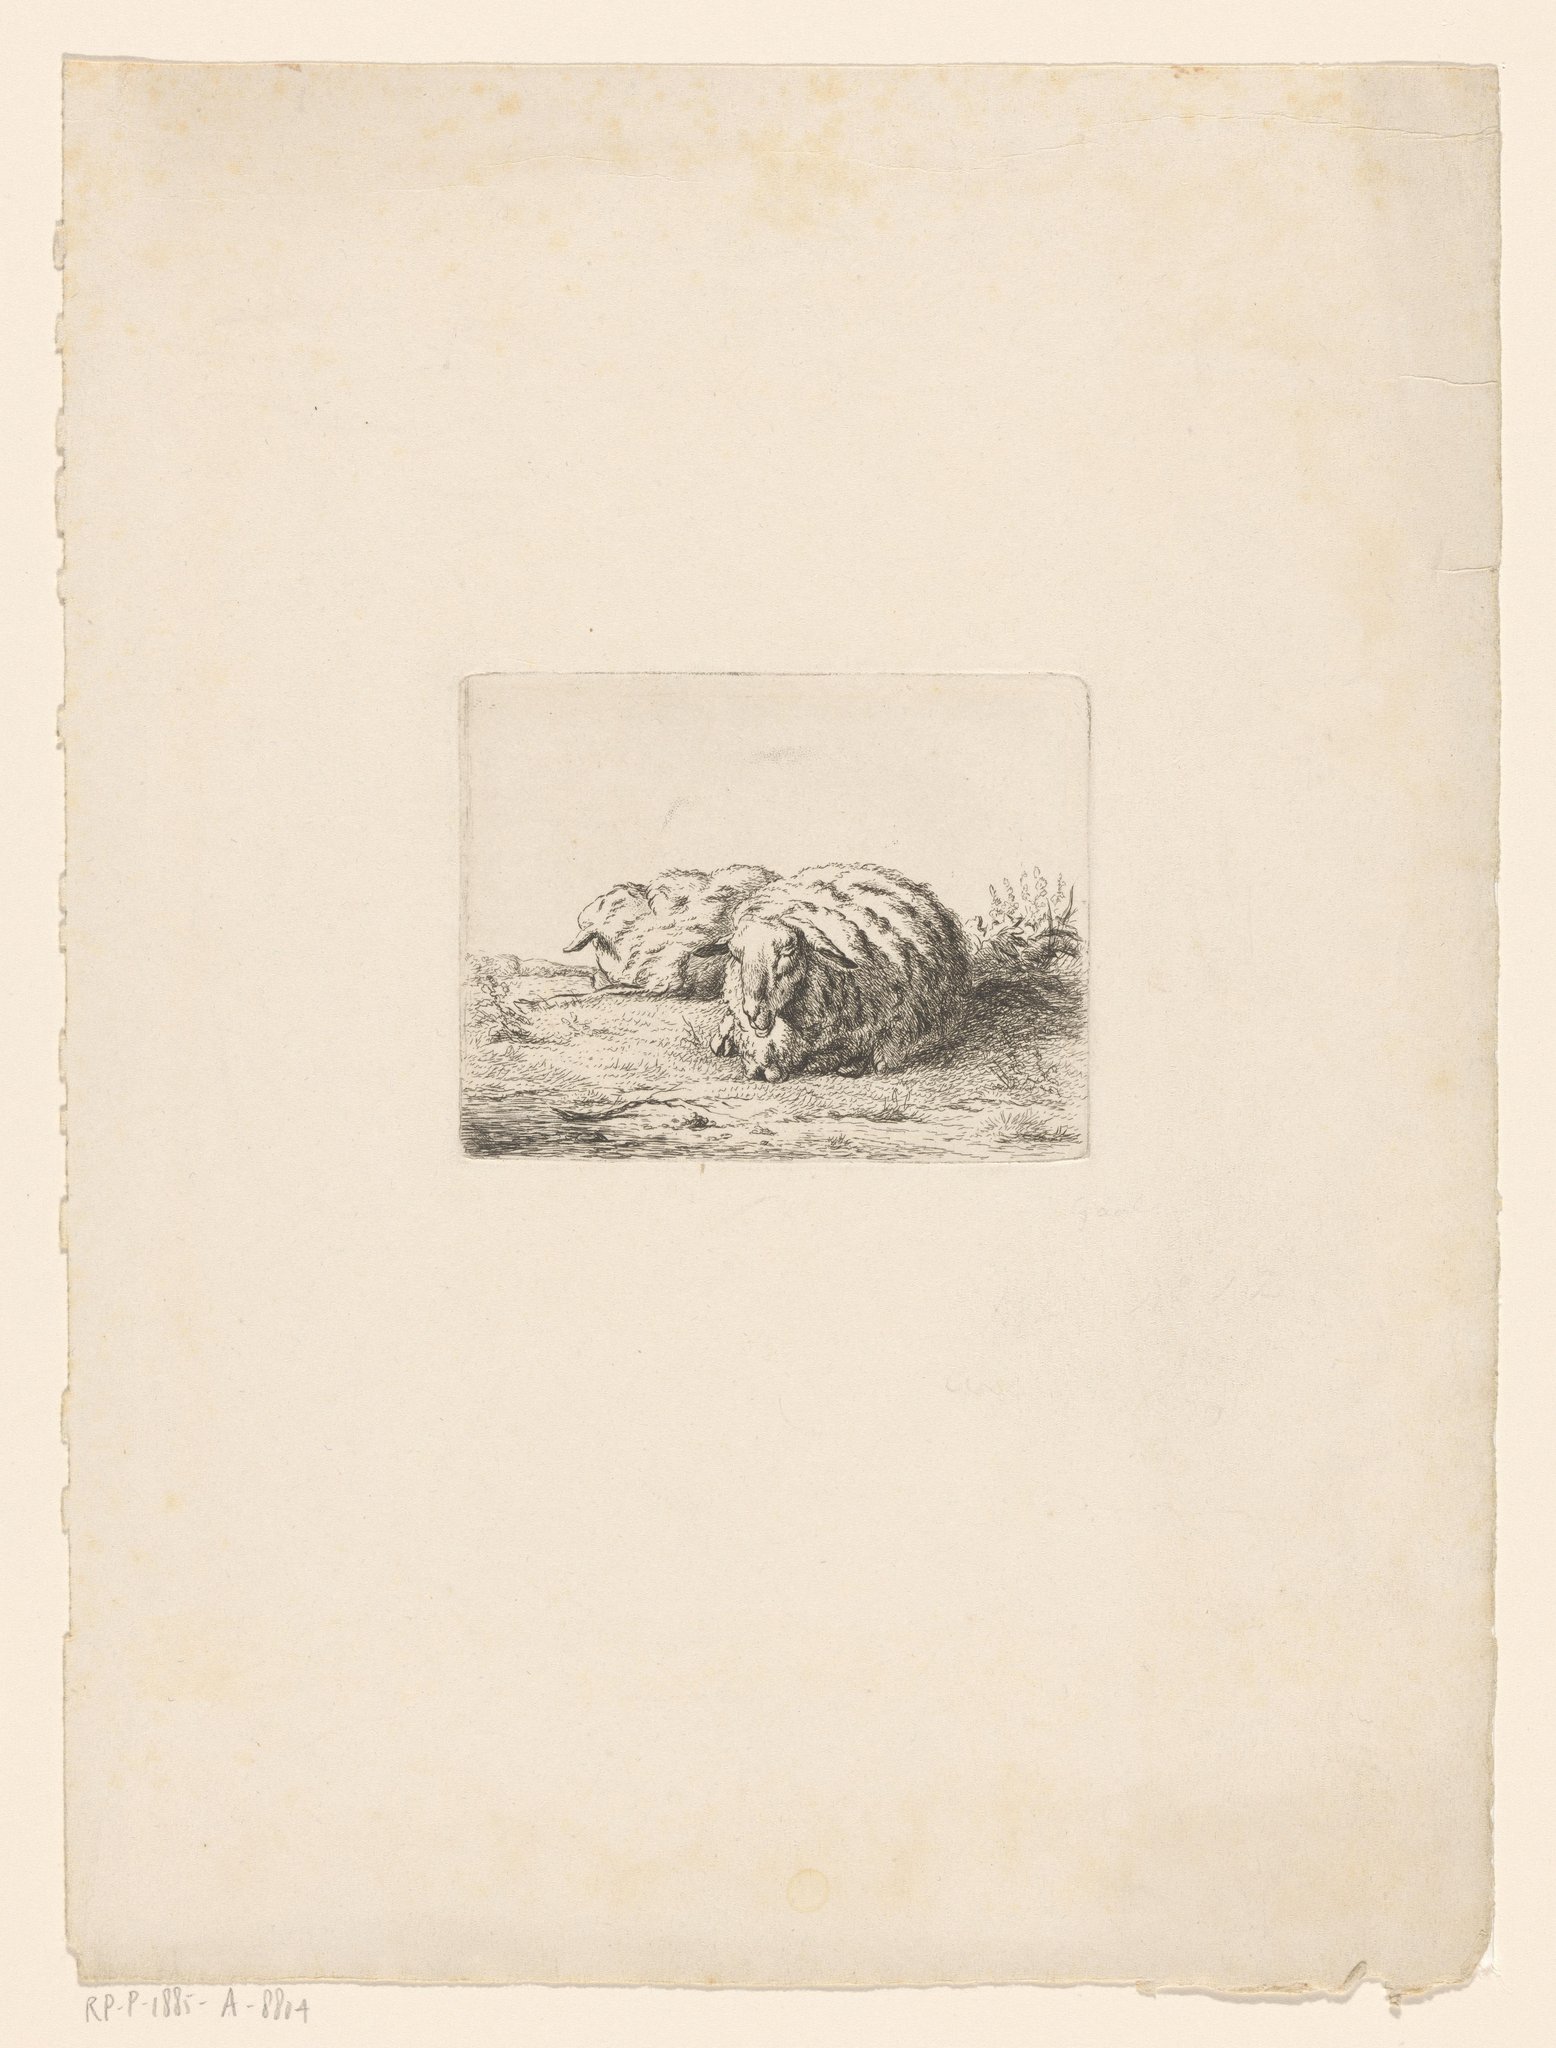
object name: print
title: Twee liggende schapen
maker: jacobus cornelis gaal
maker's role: print maker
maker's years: 1796-1866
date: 1850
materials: paper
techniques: etching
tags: sheep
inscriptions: collector's mark: Lugt 698, collector's mark: Lugt 2228